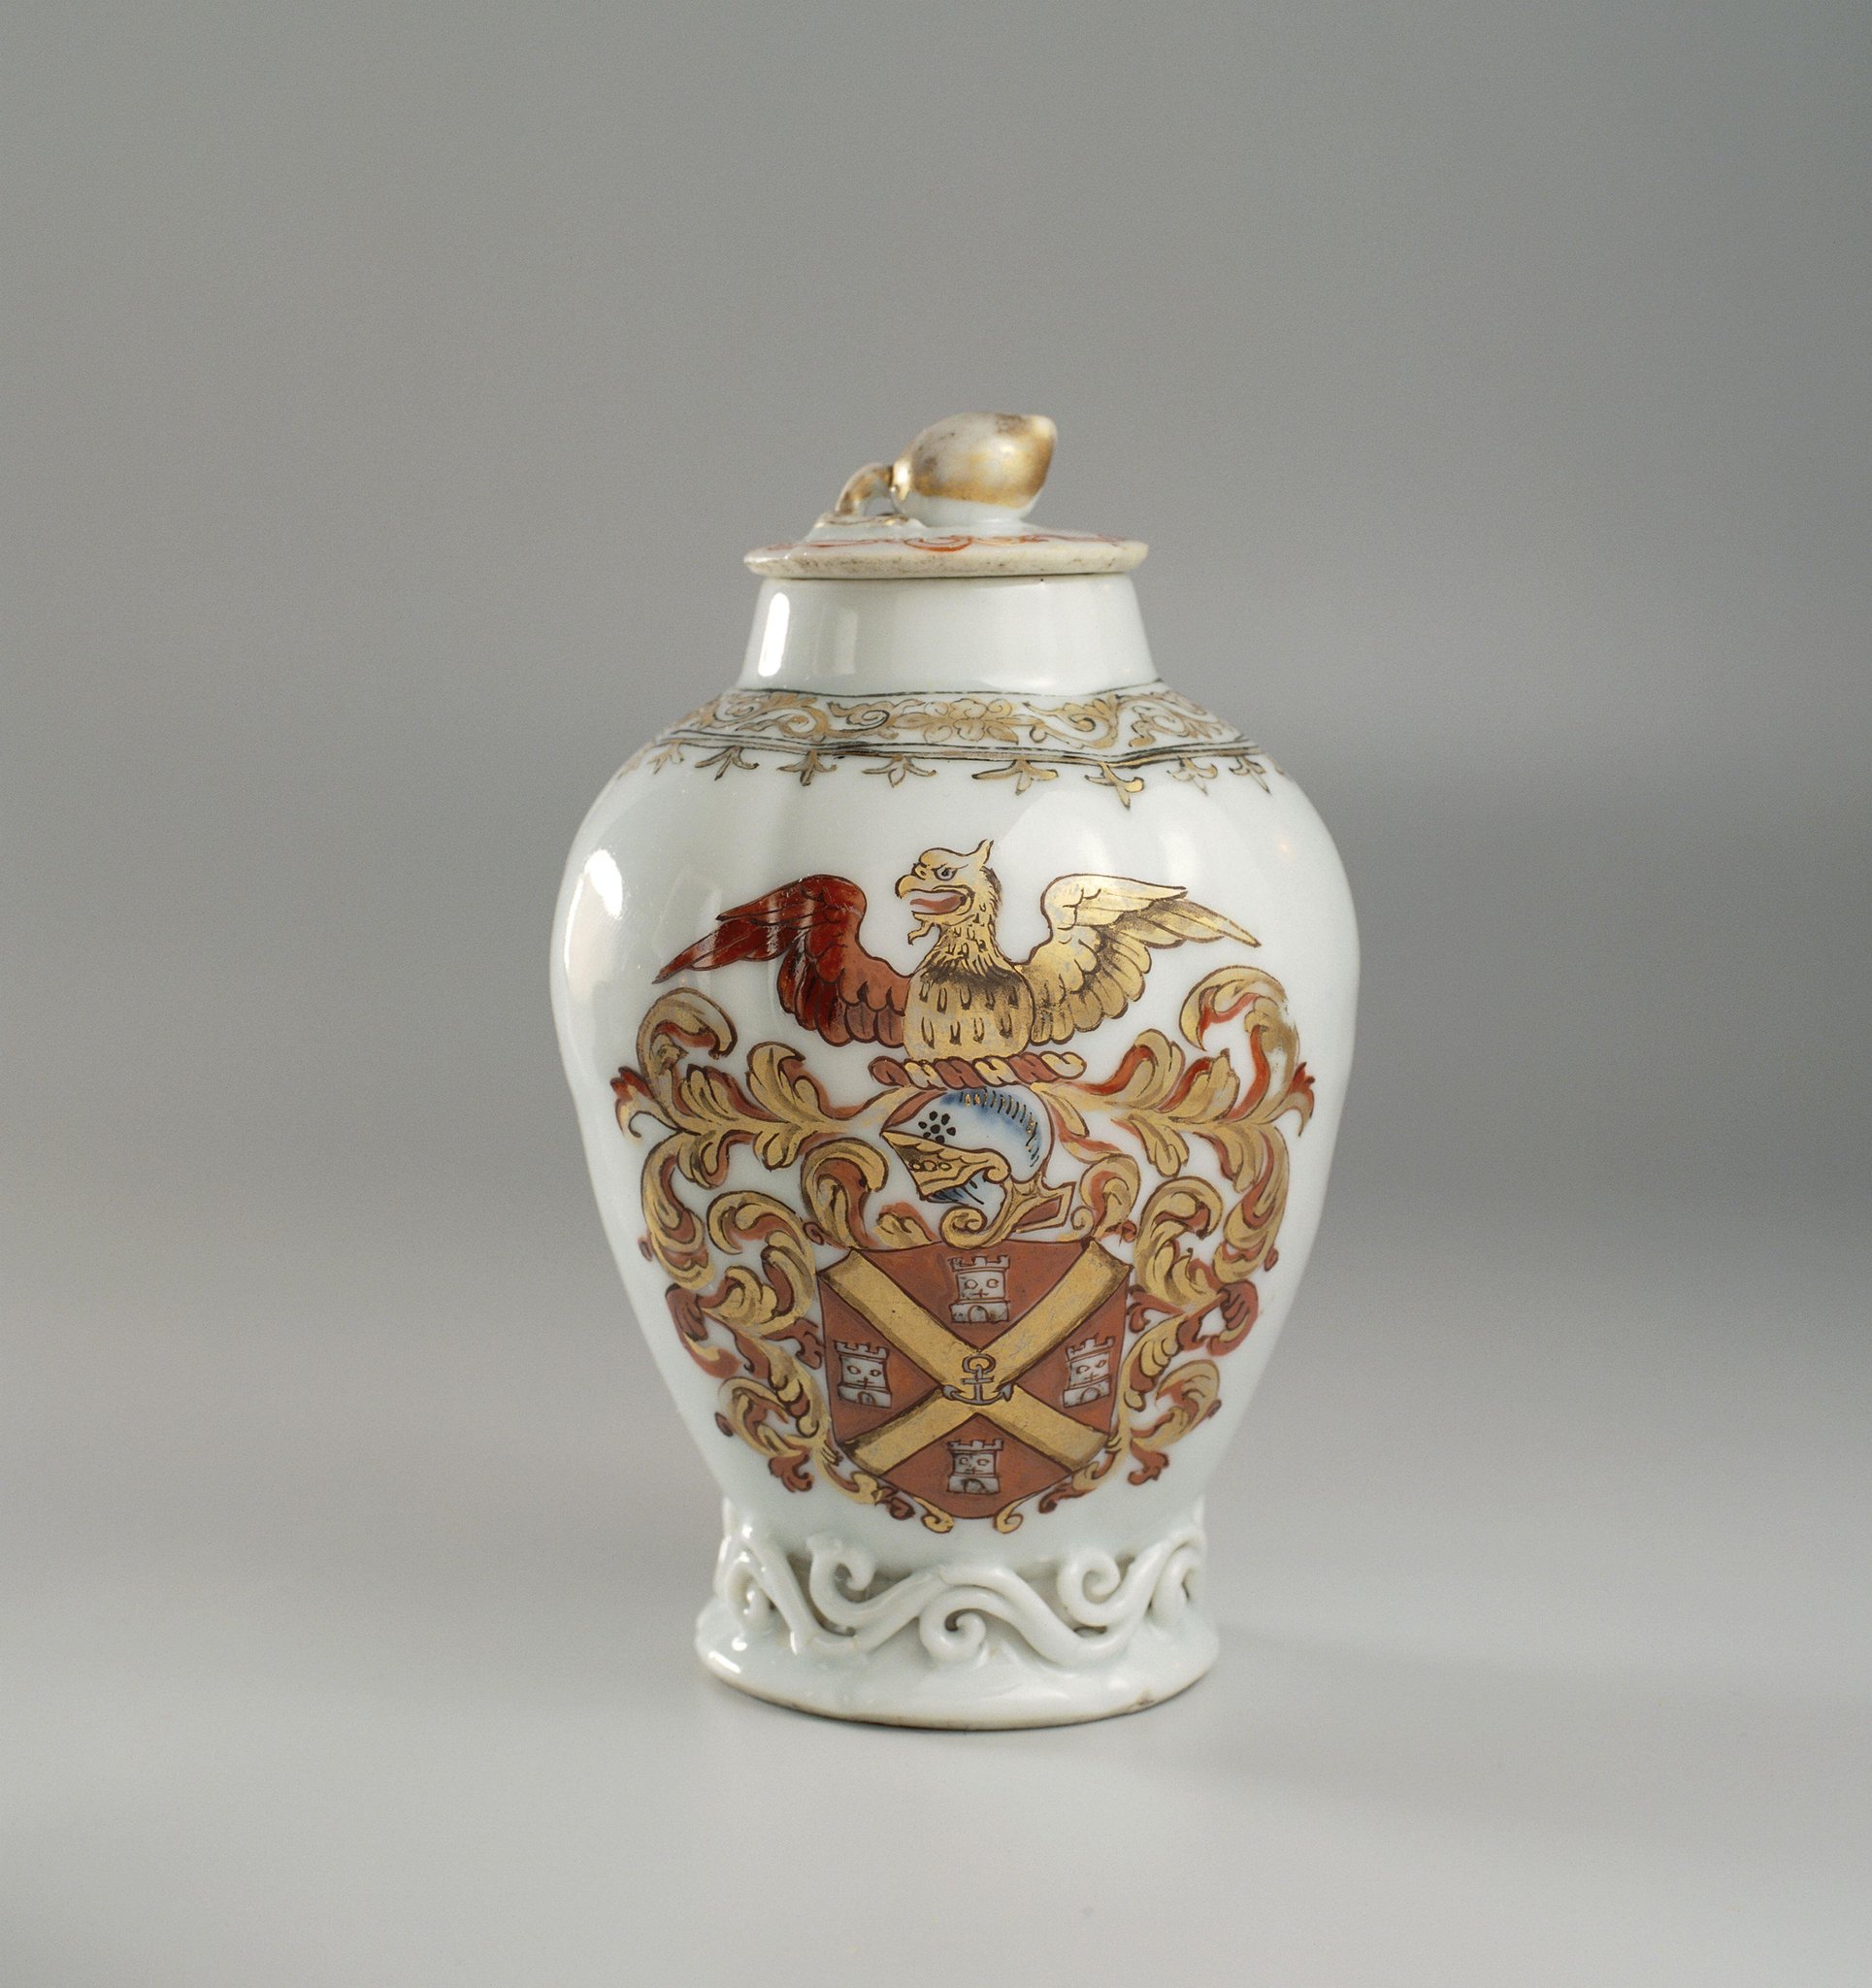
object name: tea caddy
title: Ovoid tea caddy with the arms of the De Neufville family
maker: Anonymous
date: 1740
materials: glaze, gold, paint, porcelain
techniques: firing, forming, gilding, turning, vitrification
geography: china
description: Theebus met op de buik het wapen van de familie De Neufville, gedecoreerd in goud, ijzerrood en encre de Chine. Het wapen bestaat uit vier torens en een gouden sint andreaskruis met in het midden een anker. De vorm van het schild is in Louis XIV-stijl met bovenop de griffioen als helmteken. Het wapen is omgeven door een dekkleed van bladranken. Rond de voet een golvenmotief in reliëf. Op de schouder een band bladranken en spearheads. Bovenop de theebus een dekselknop in de vorm van een perzik, maar deze deksel behoort wellicht niet bij de theebus.